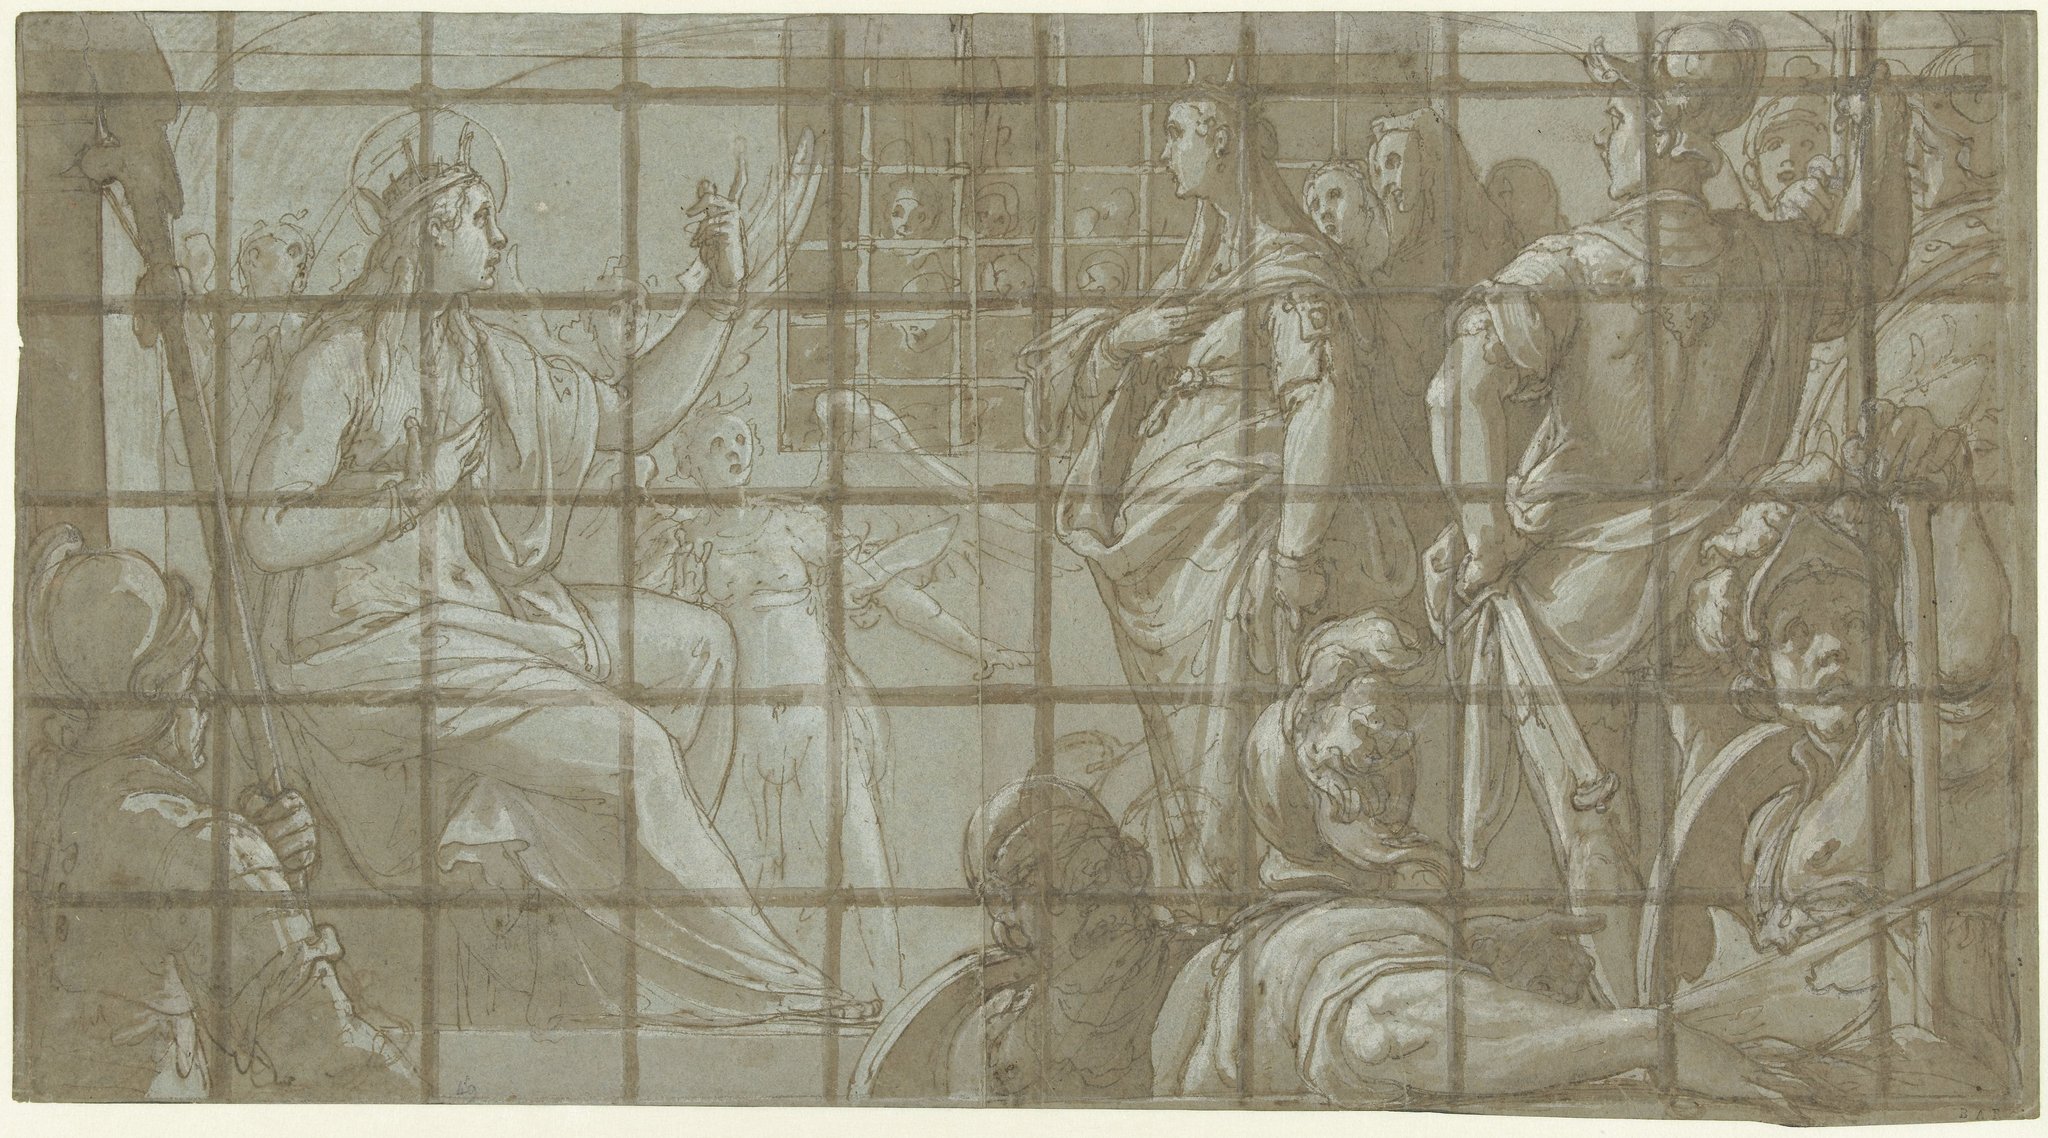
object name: drawing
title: Keizerin Faustina door de heilige Catharina in haar kerker bekeerd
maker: federico zuccaro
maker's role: draughtsman, print maker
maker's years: 1540-1609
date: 1570-1574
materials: ink, paper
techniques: brush, pen